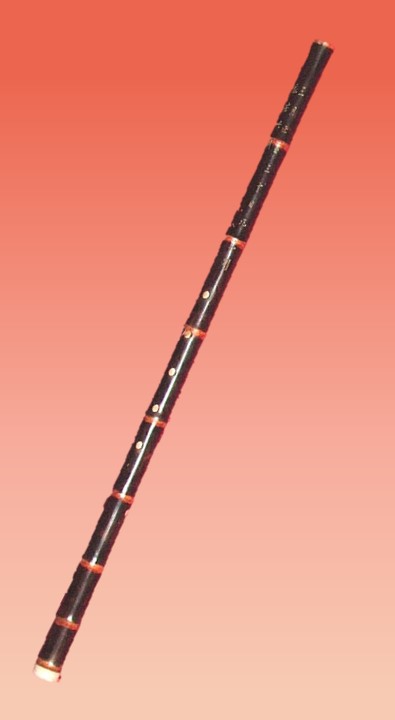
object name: xiao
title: Xiao (簫)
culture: chinese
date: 1867-1900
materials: bamboo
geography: china